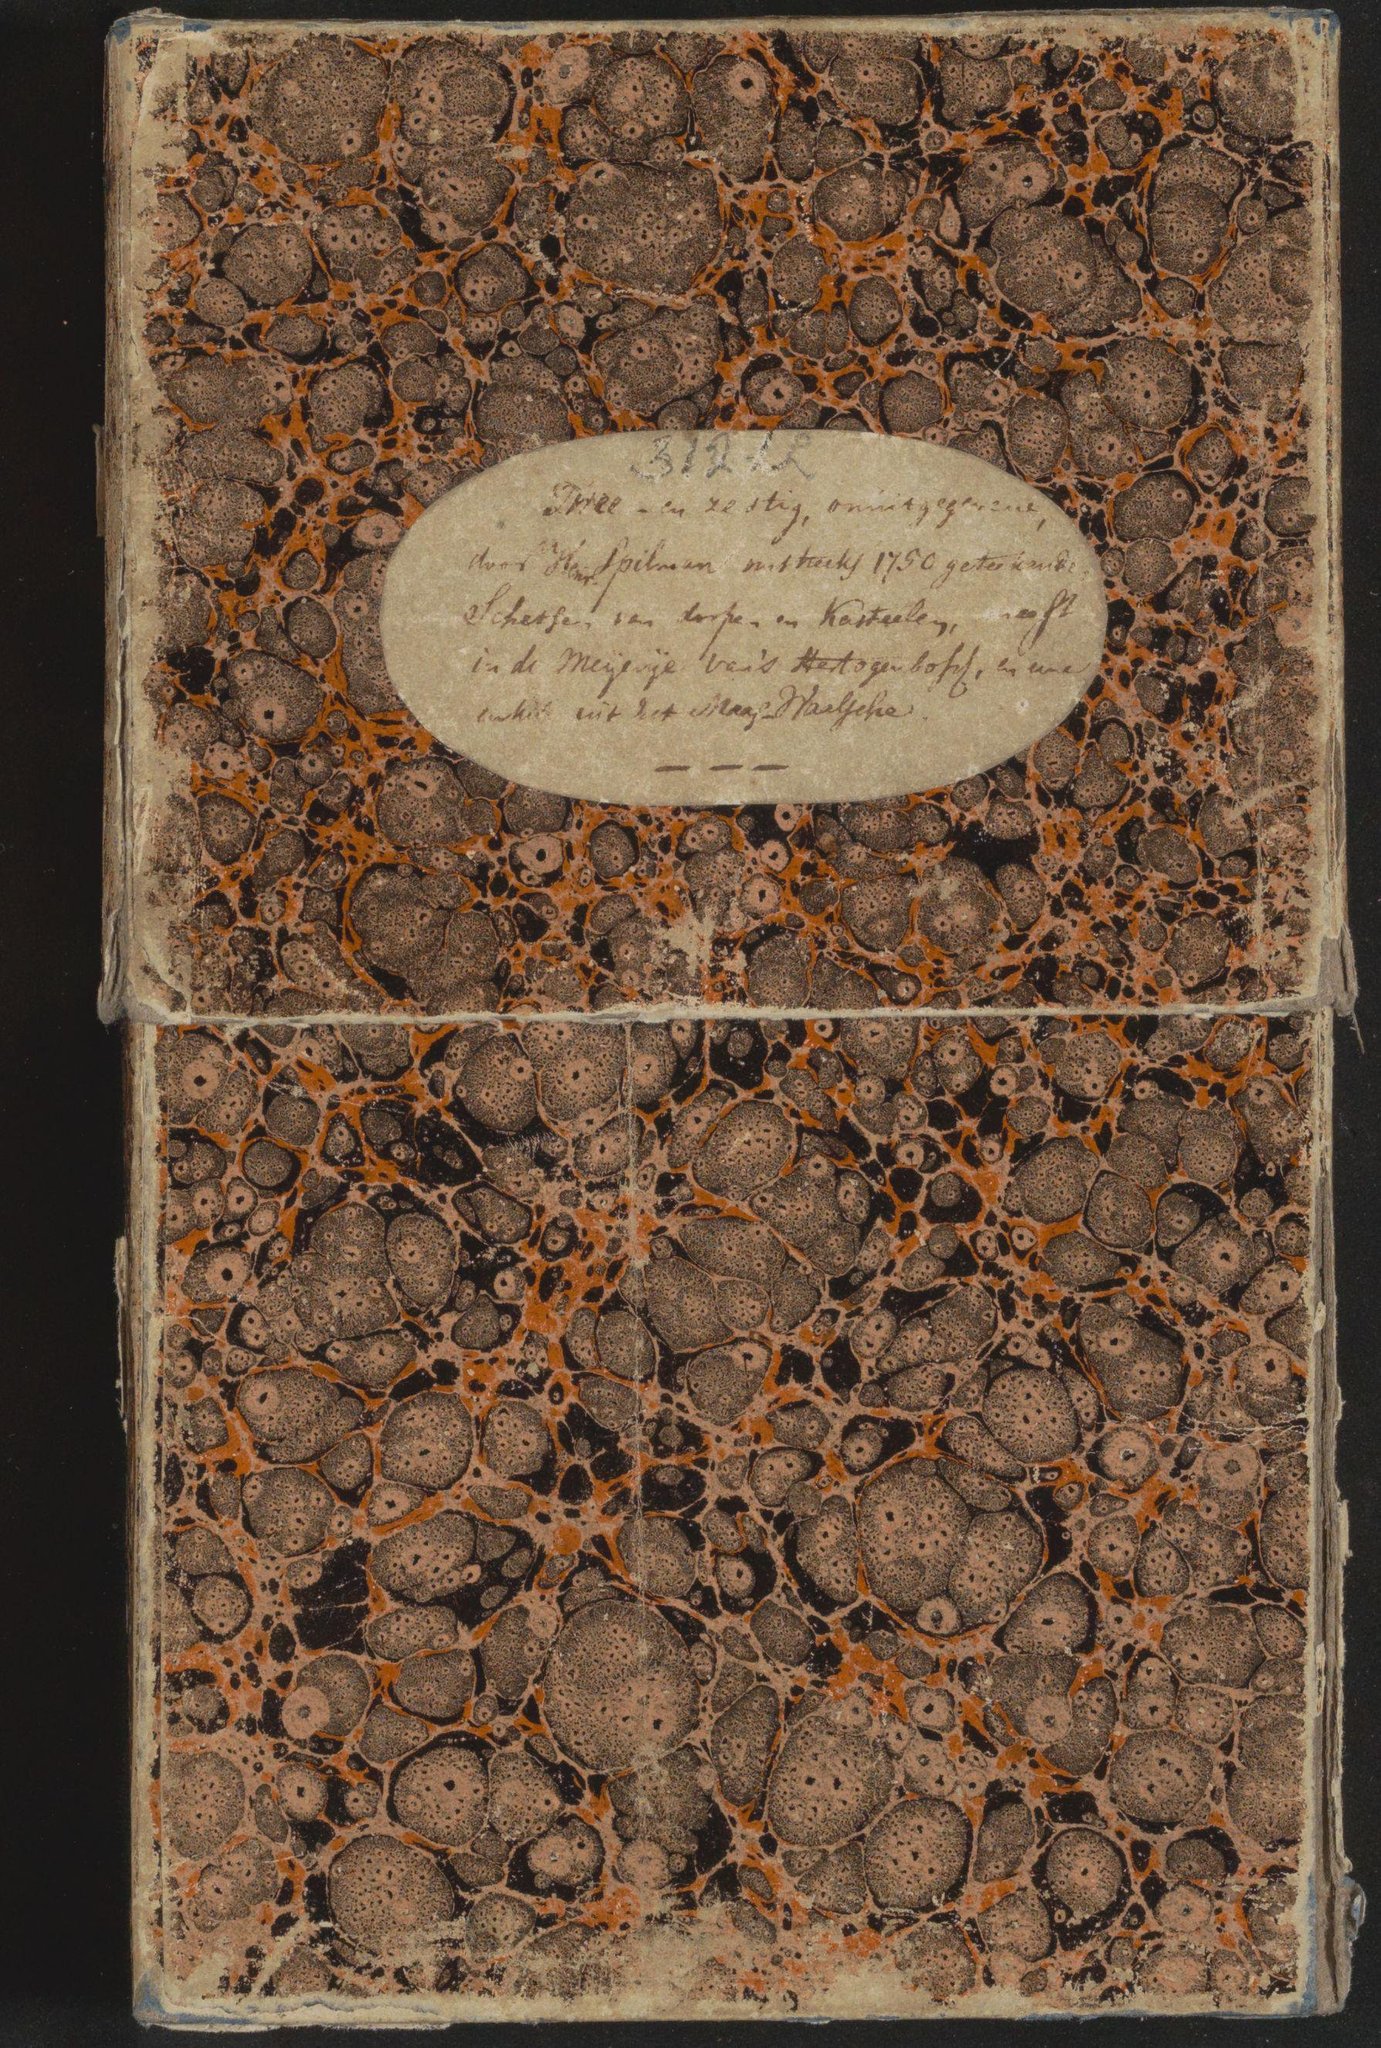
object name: sketchbook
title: Schetsboek met 65 bladen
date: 1701-1759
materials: ink, paper, parchment, pencil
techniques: brush, pen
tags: prospect of village, silhouette of village, castle, prospect of city, town panorama, silhouette of city, country-house, oss, grave, veghel, rosmalen, gemert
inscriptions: annotation: ‘Deze katern ... [...]’, date and inscription: ‘No IX. 63. Bladen. (geteekend door H Spilman)./ H.S, geb te Amst. 1721 (Immerzeel, Levens der Ned. Schilders, III. 104)/ Dit boek hoort toe aan/ Hendrik Spilman/ Hend de Winter/ Door koop aan aan J Verstegen/ 13 juni 1791/ In 1847 door koop, aan Az Schinkel/ en door dezen 1848 afgestaan aan J.T. Bode[...]’, annotation: ‘[...]’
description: Tussen het voorste schutblad en blad 1 is een vel geplakt met een handgeschreven lijst van de tekeningen in het schetsboek. Blad 4(R) is blanco, net als de verso van de bladen in het schetsboek met uitzondering van blad 24(V), 50(V) en 54(V).